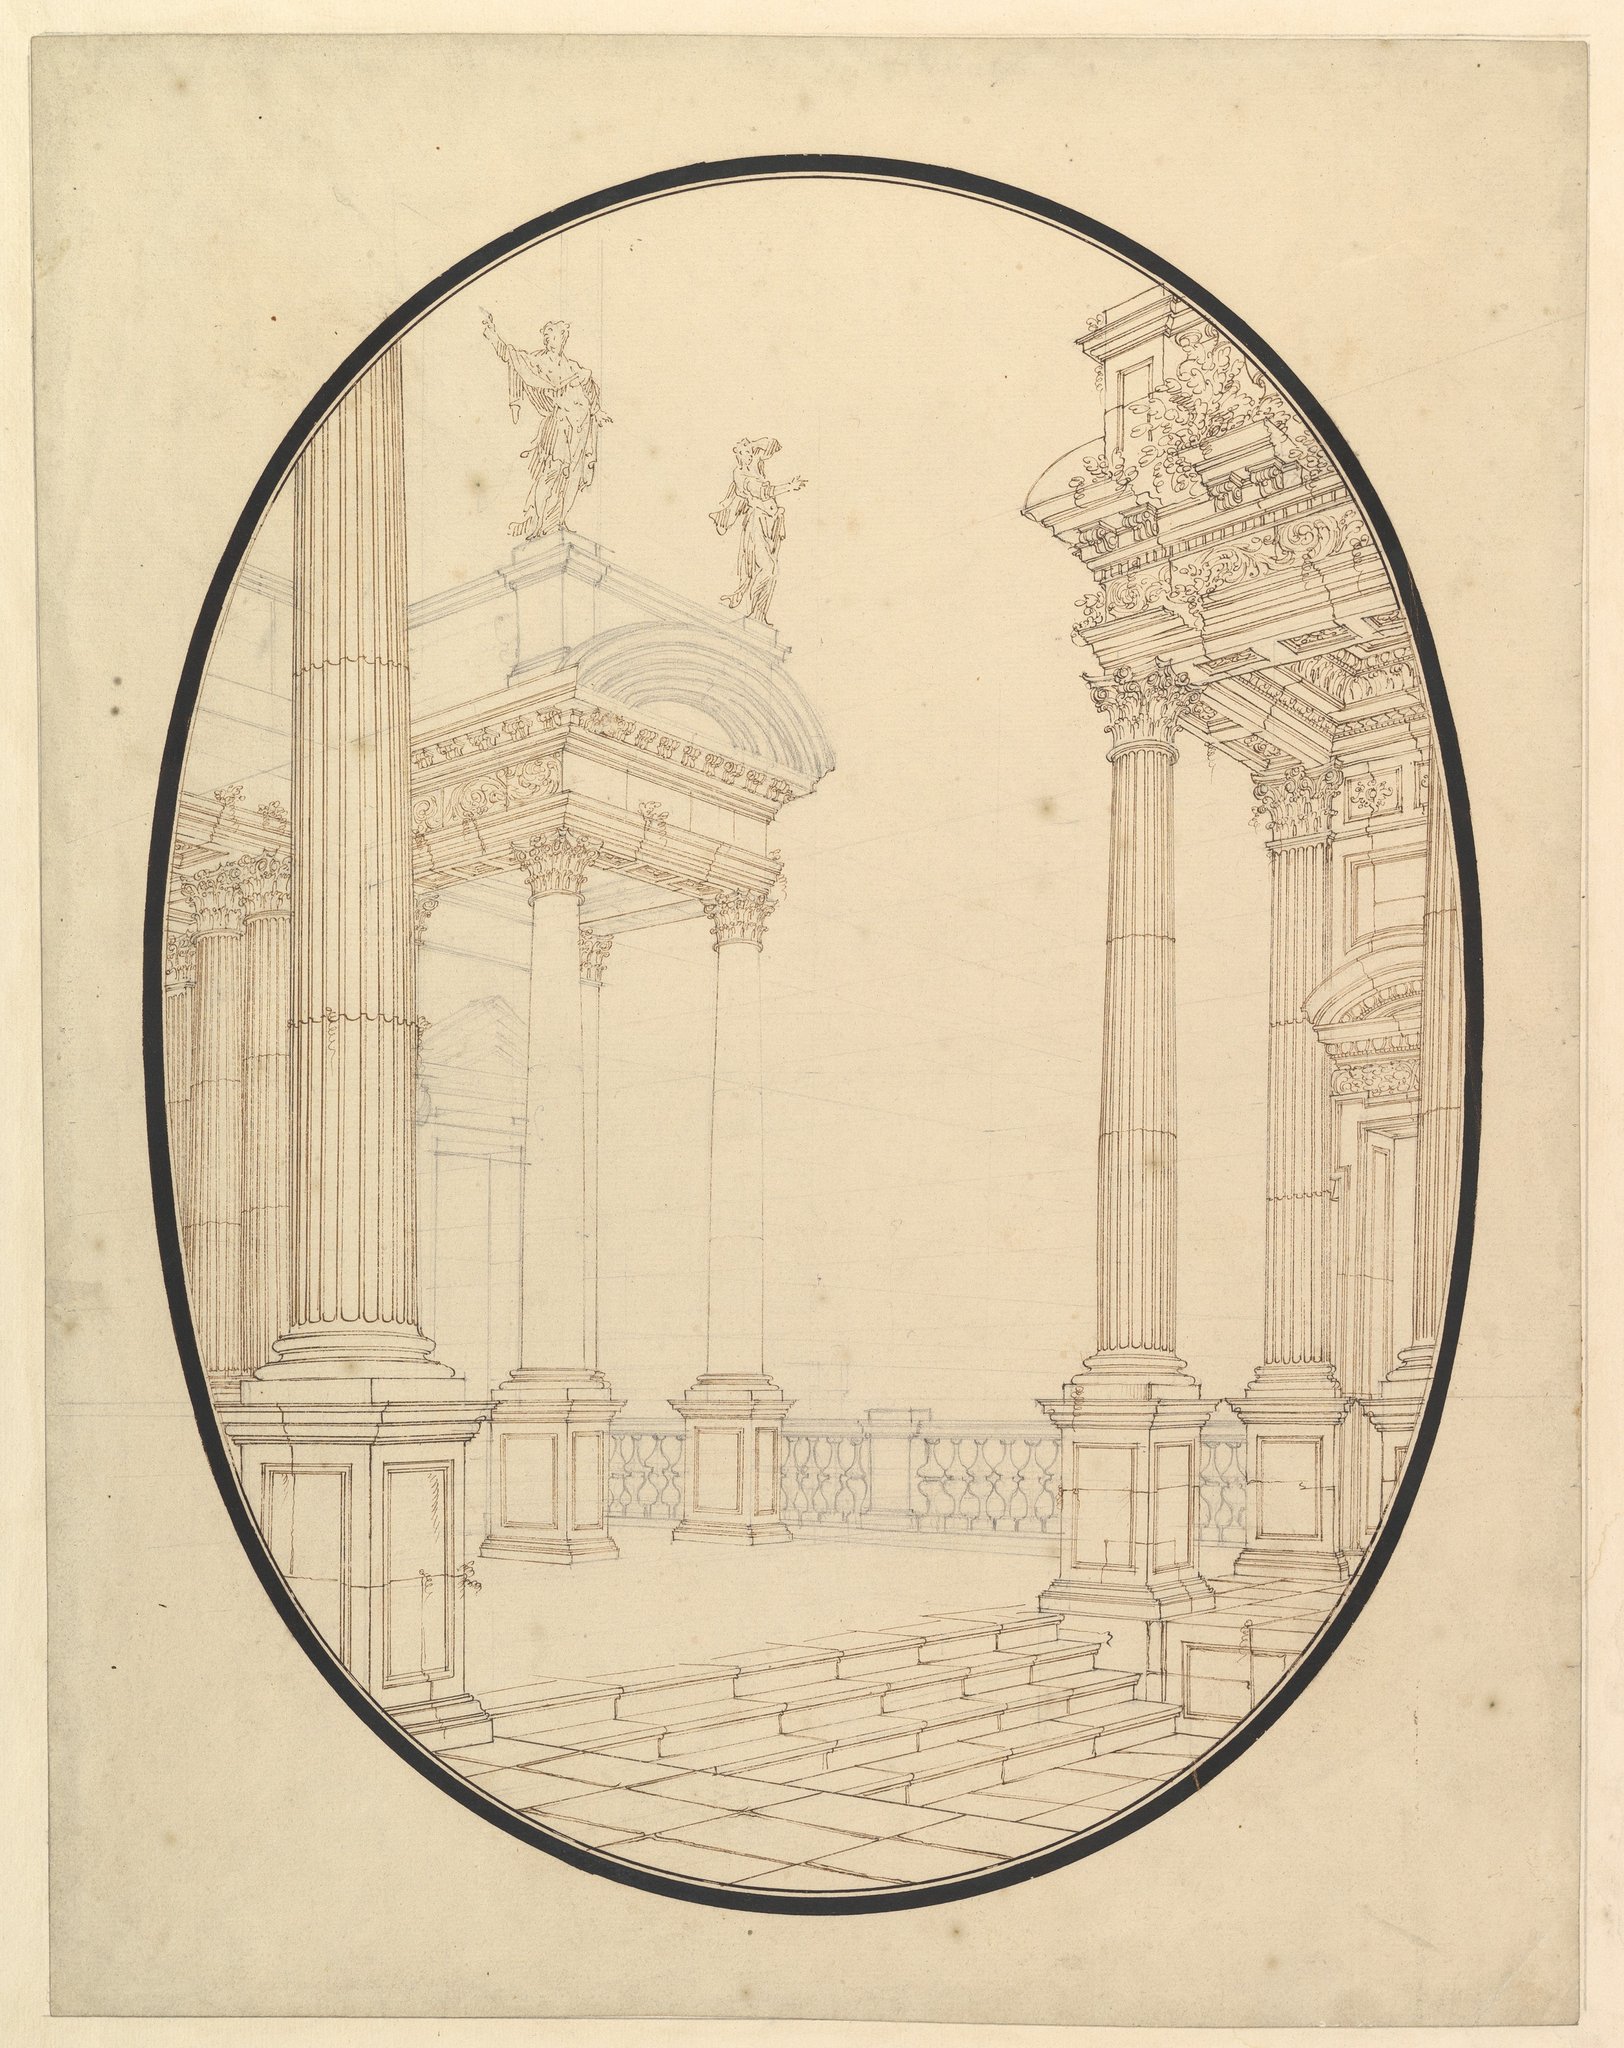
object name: drawing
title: Architectural Perspective, in an Oval: Porch of a Palace with Corinthian Columns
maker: ferdinando galli bibiena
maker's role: artist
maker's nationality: italian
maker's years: 1657-1743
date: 1657-1743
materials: chalk, ink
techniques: pen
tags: architecture,columns,palaces